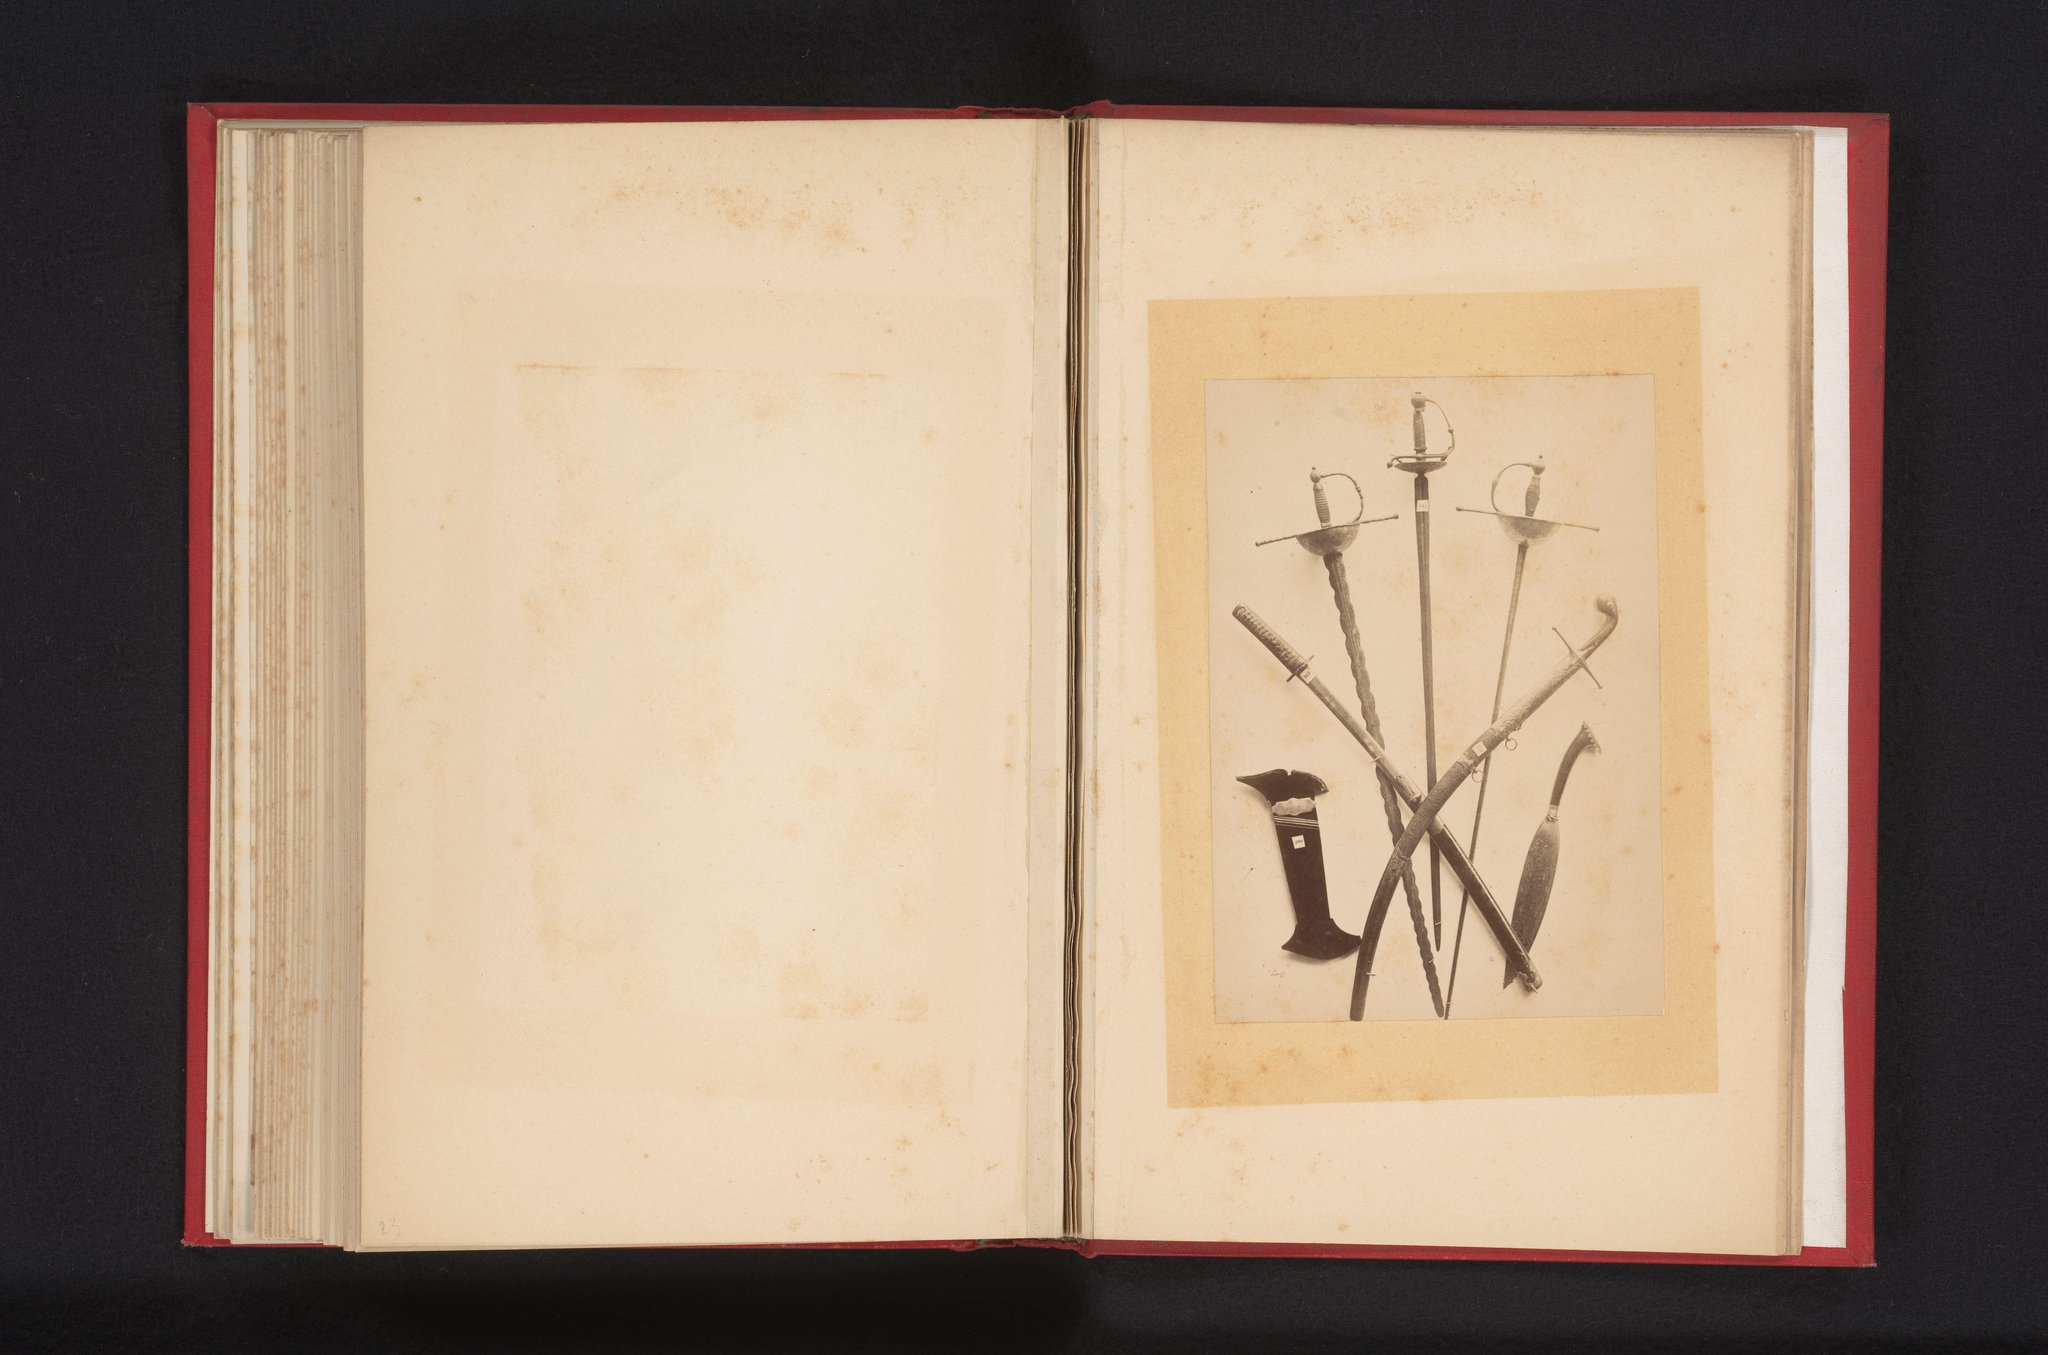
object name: photograph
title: Zwaarden en sabels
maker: Anonymous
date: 1873-1878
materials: photographic support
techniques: albumen print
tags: hacking and thrusting weapons (with name), hacking and thrusting weapons: sword